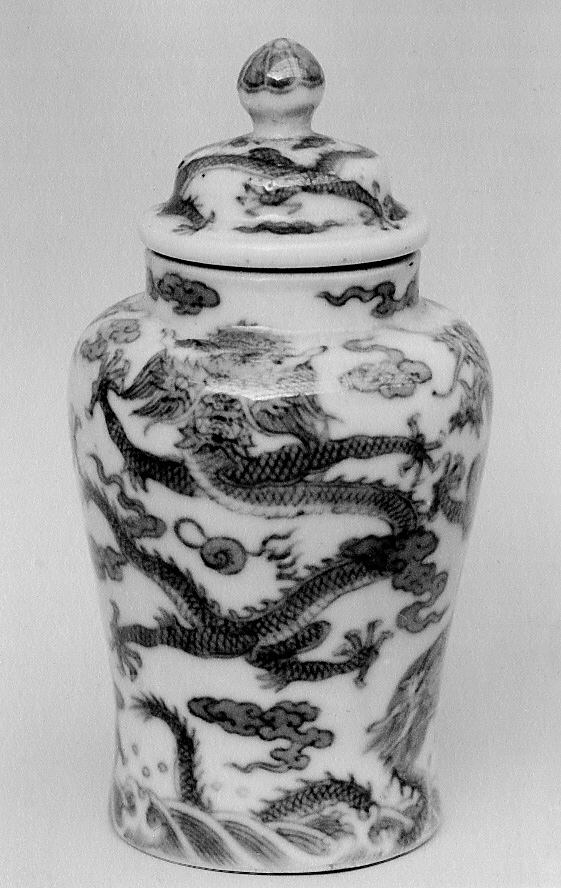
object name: snuff bottle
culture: chinese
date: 1723-1735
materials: porcelain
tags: dragons